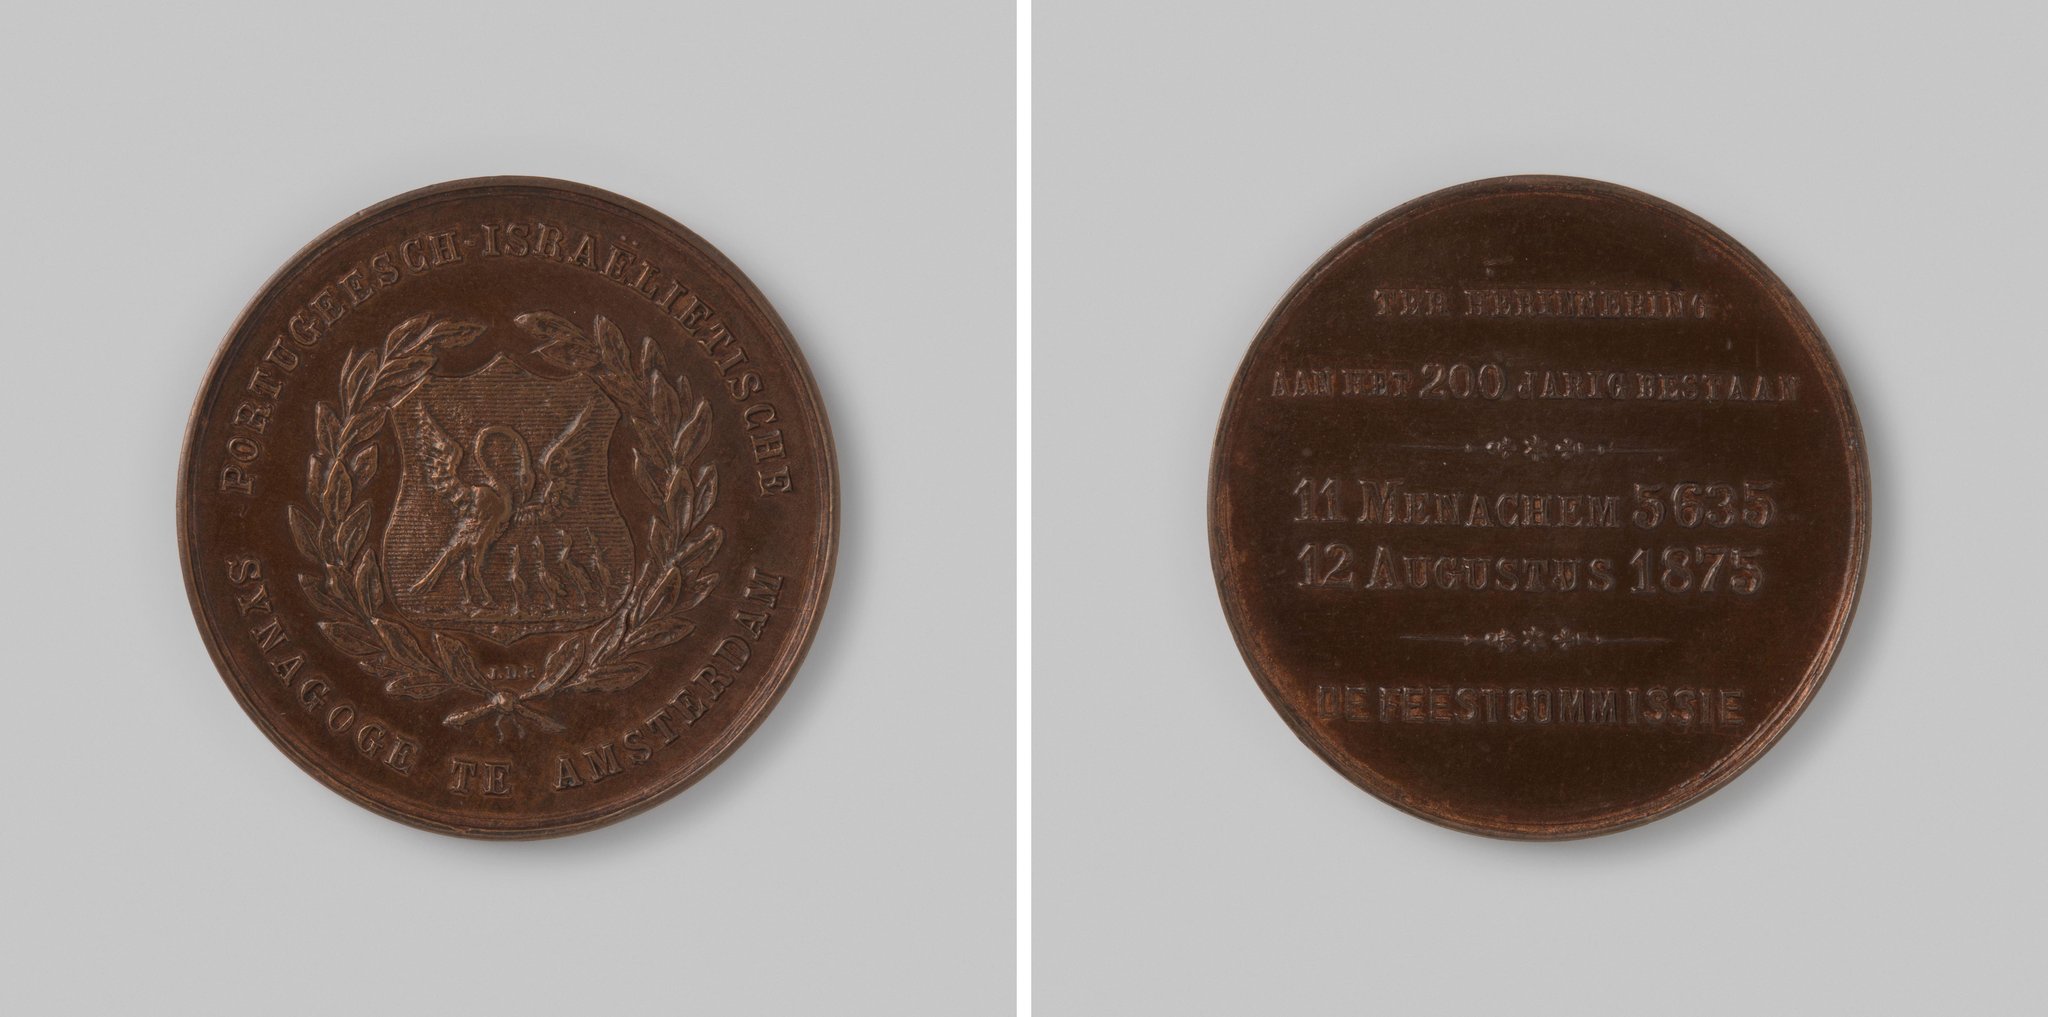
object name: history medal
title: Tweehonderdjarig bestaan van de Portugeesch-Israëlietische Synagoge te Amsterdam 1875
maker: jan postmus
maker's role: silversmith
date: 1875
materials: bronze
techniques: striking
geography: amsterdam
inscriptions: inscription: ‘TER HERINNERING / AAN HET 200 JARIG BESTAAN / 11 MENACHEN 5635 / 12 AUGUSTUS 1875 / DE FEESTCOMMISSIE’, circumscription: ‘PORTUGEESCH-ISRAËLITISCHE / SYNAGOGE TE AMSTERDAM’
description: Bronzen penning, op de voorzijde een wapenschild, waarop een pelikaan met jongen, tussen samengebonden lauwertakken, met omschrift, op de keerzijde vijf regels tekst.